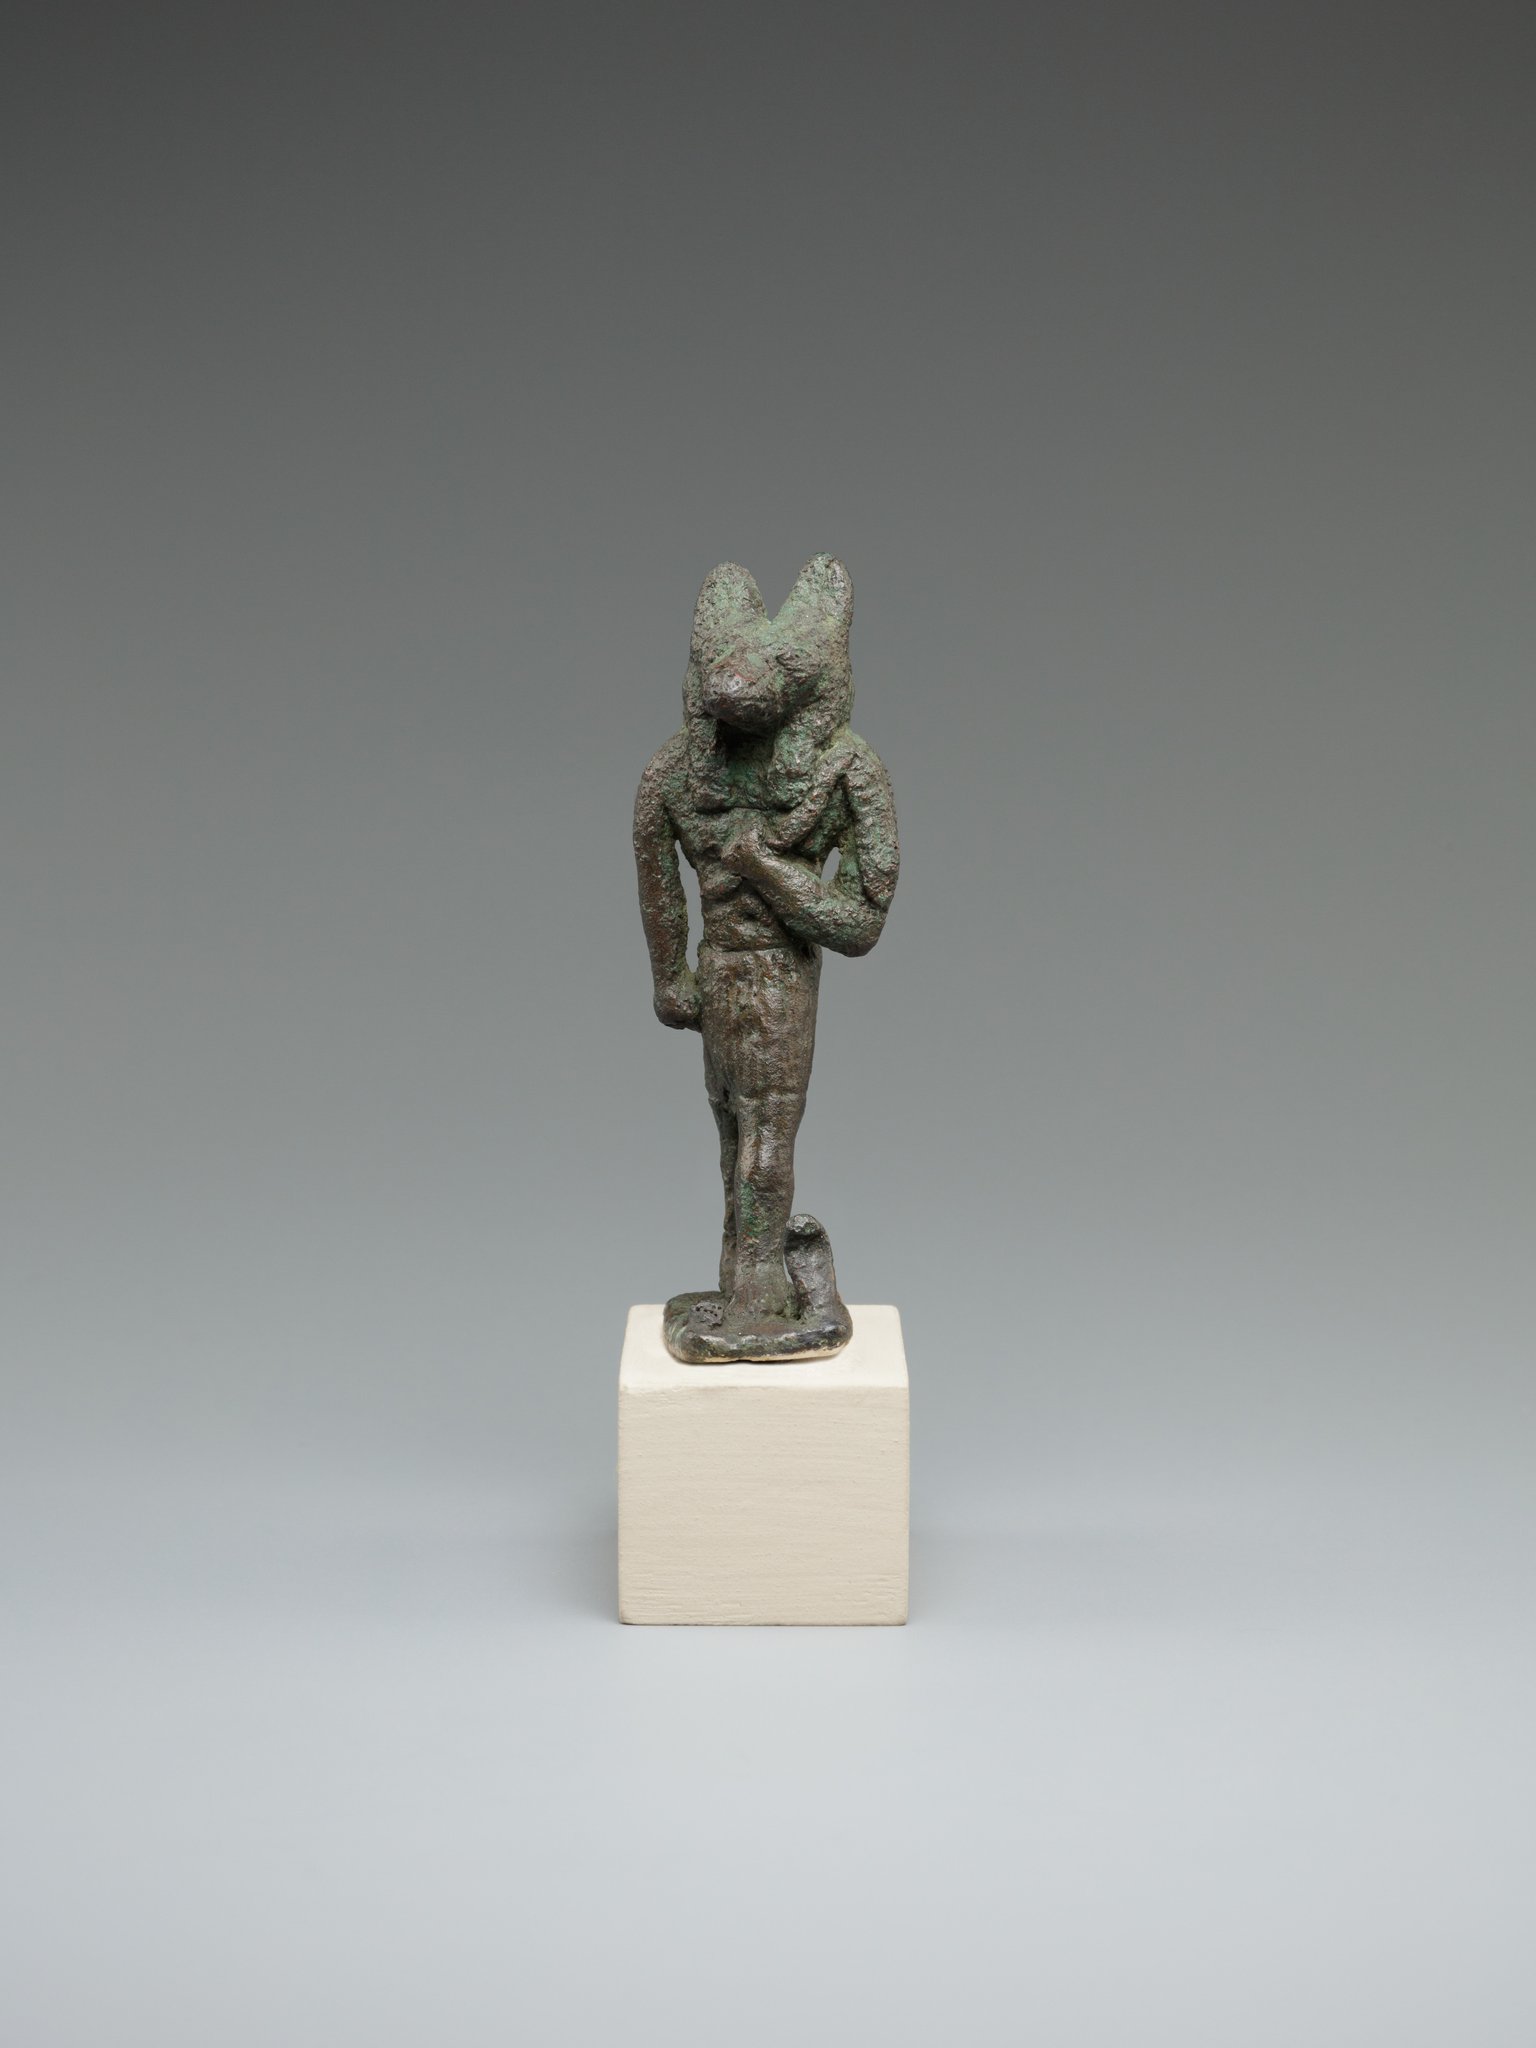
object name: statuette, anubis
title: Anubis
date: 664-630 BCE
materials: alloy, bronze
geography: egypt